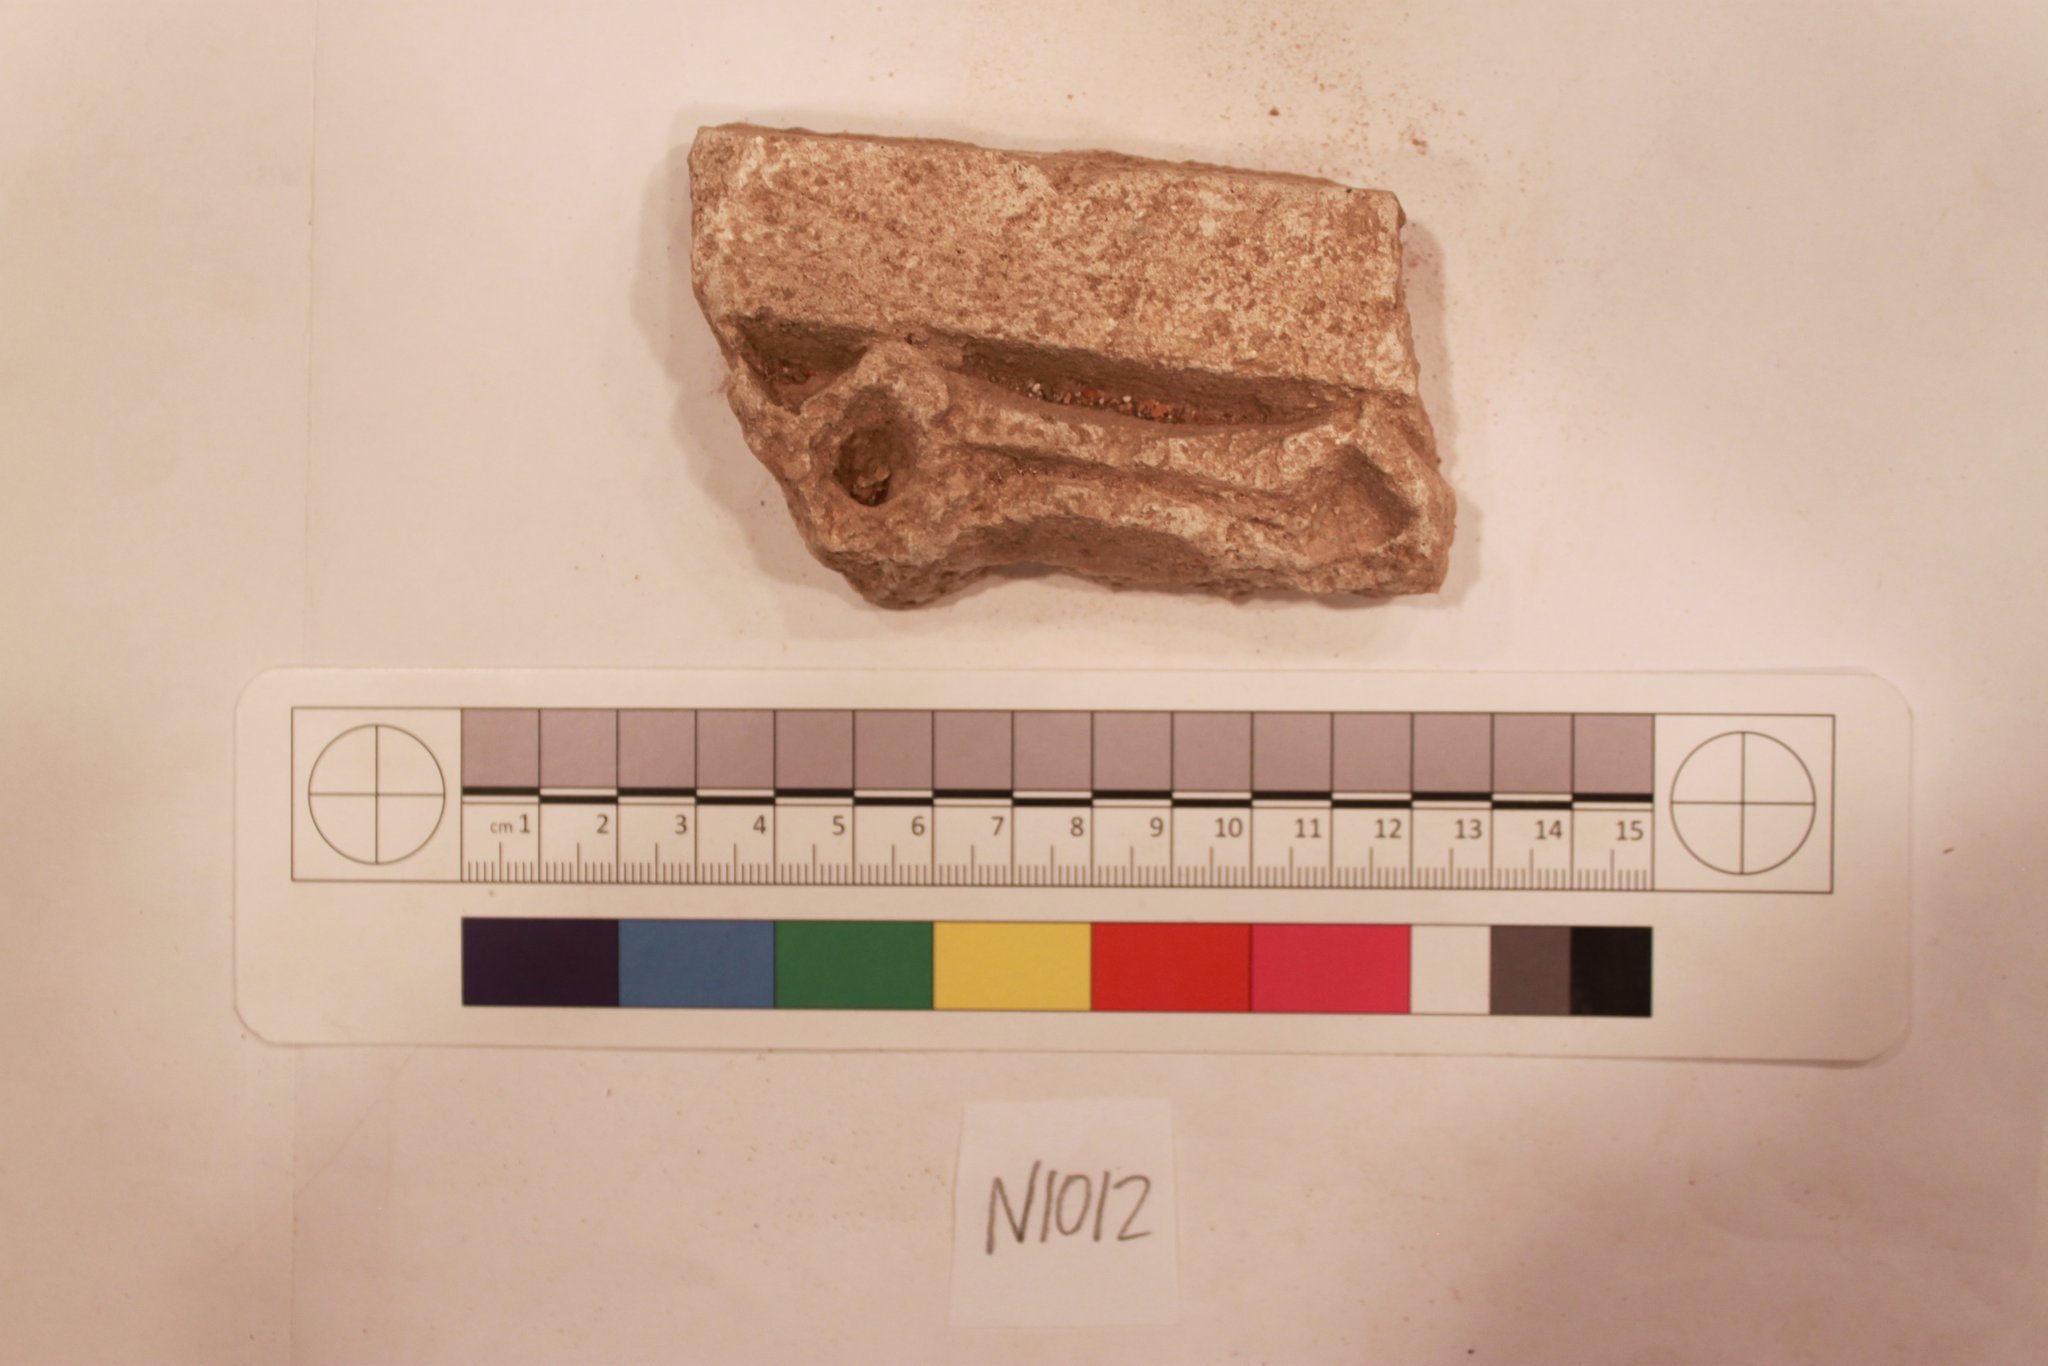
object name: fragment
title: Stucco Fragment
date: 701-1200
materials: plaster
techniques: carving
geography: iran